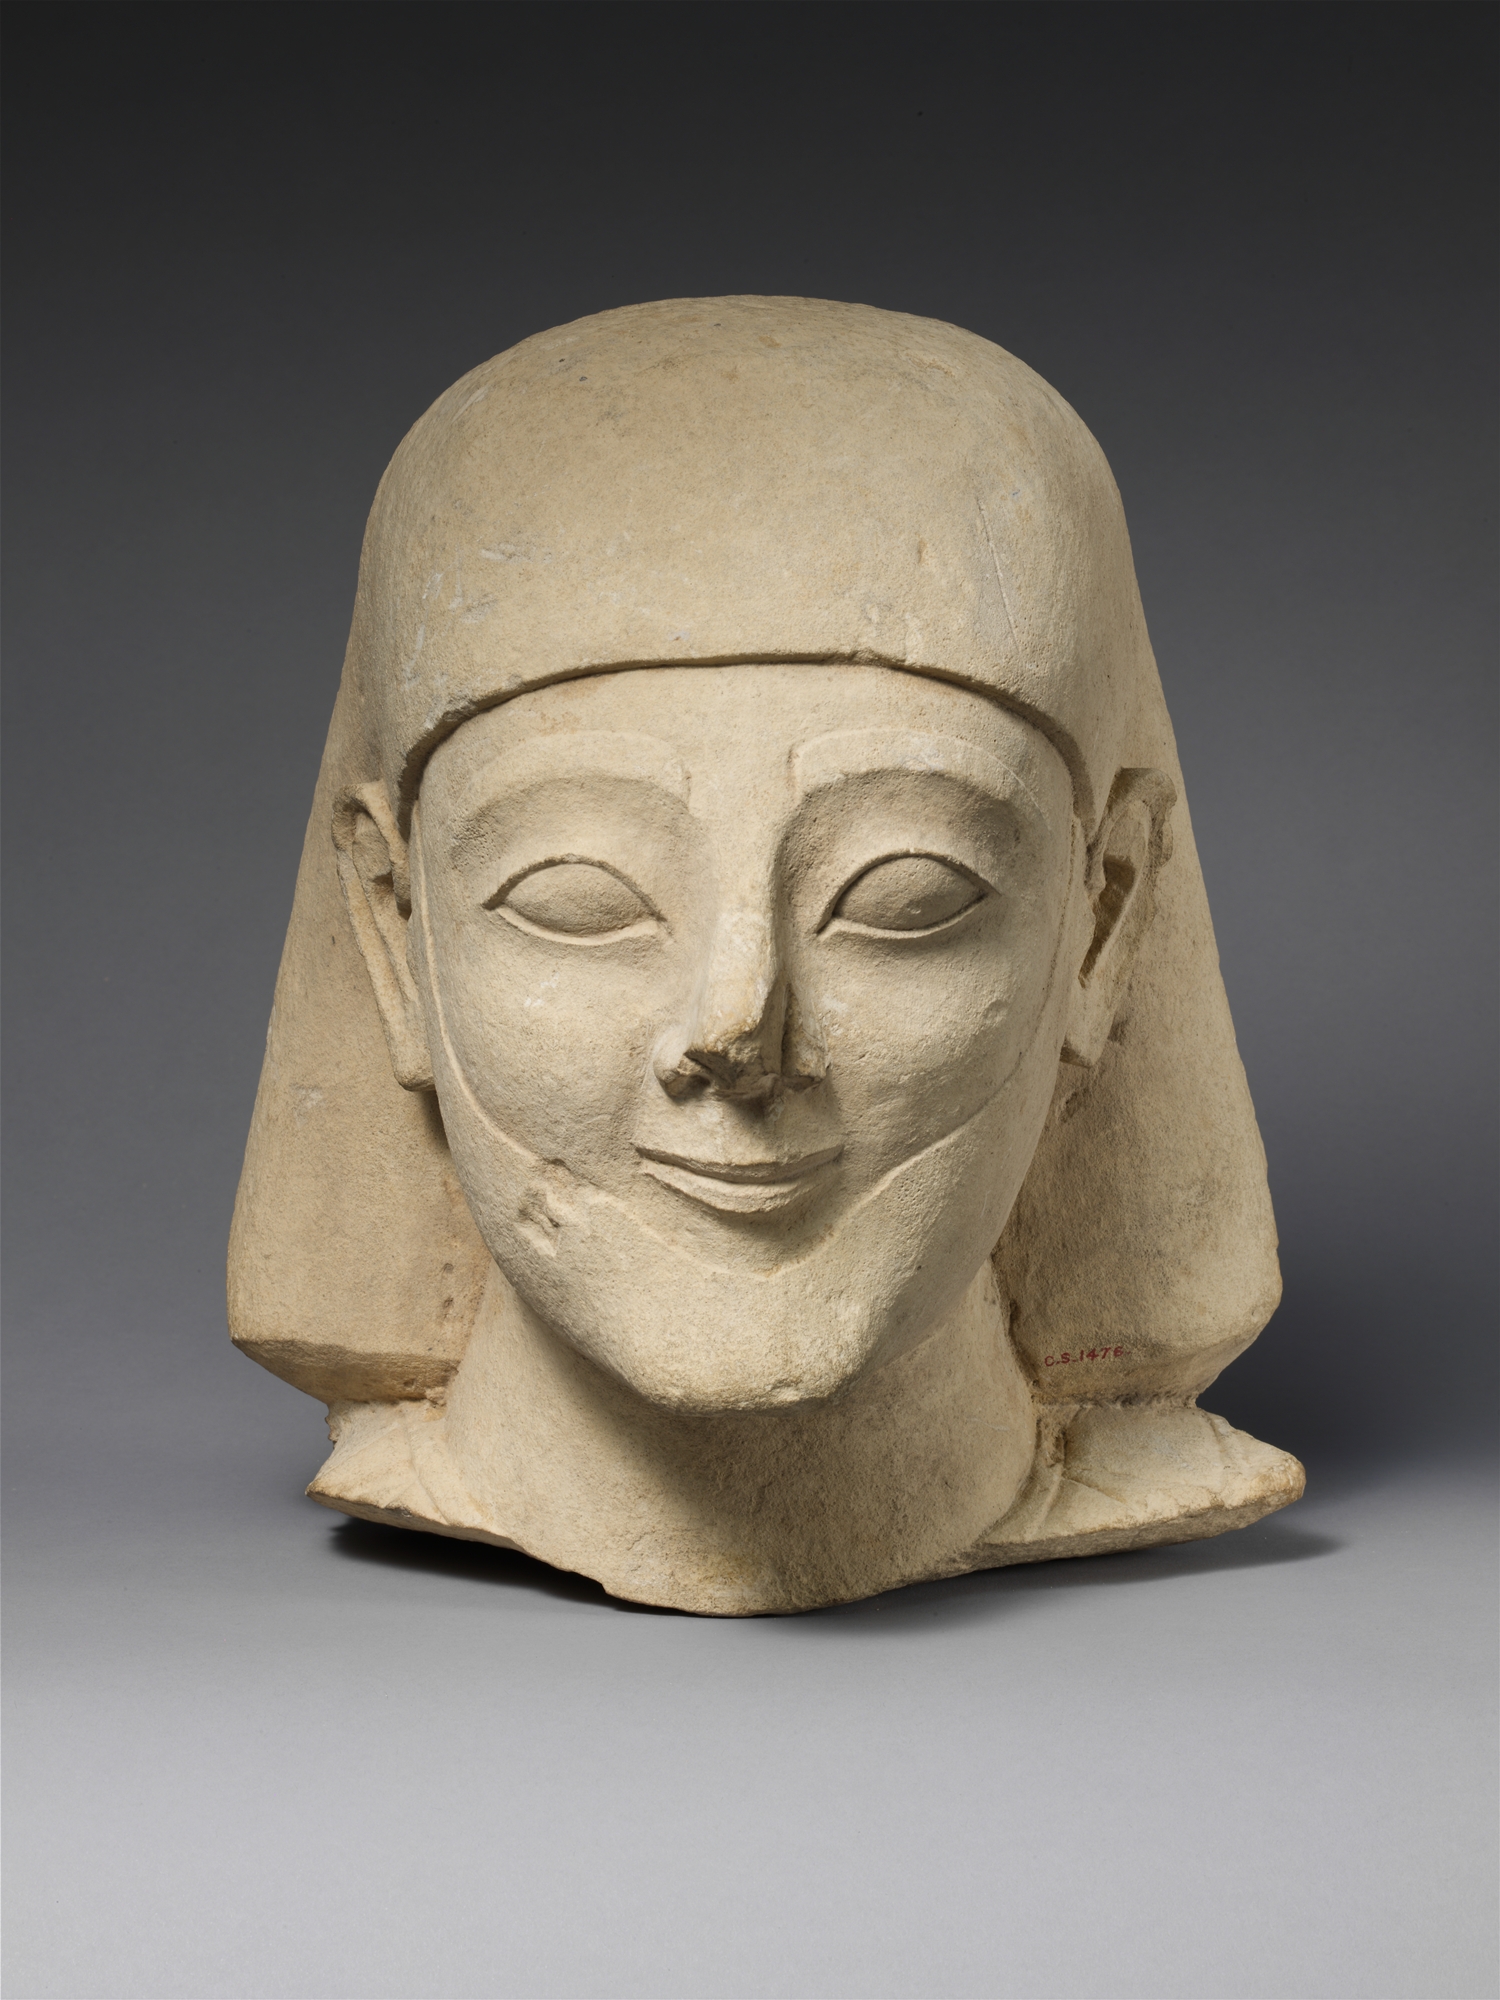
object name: head of a man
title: Limestone head of a bearded male with a plain headdress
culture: cypriot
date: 567-535 BCE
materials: limestone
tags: heads,men